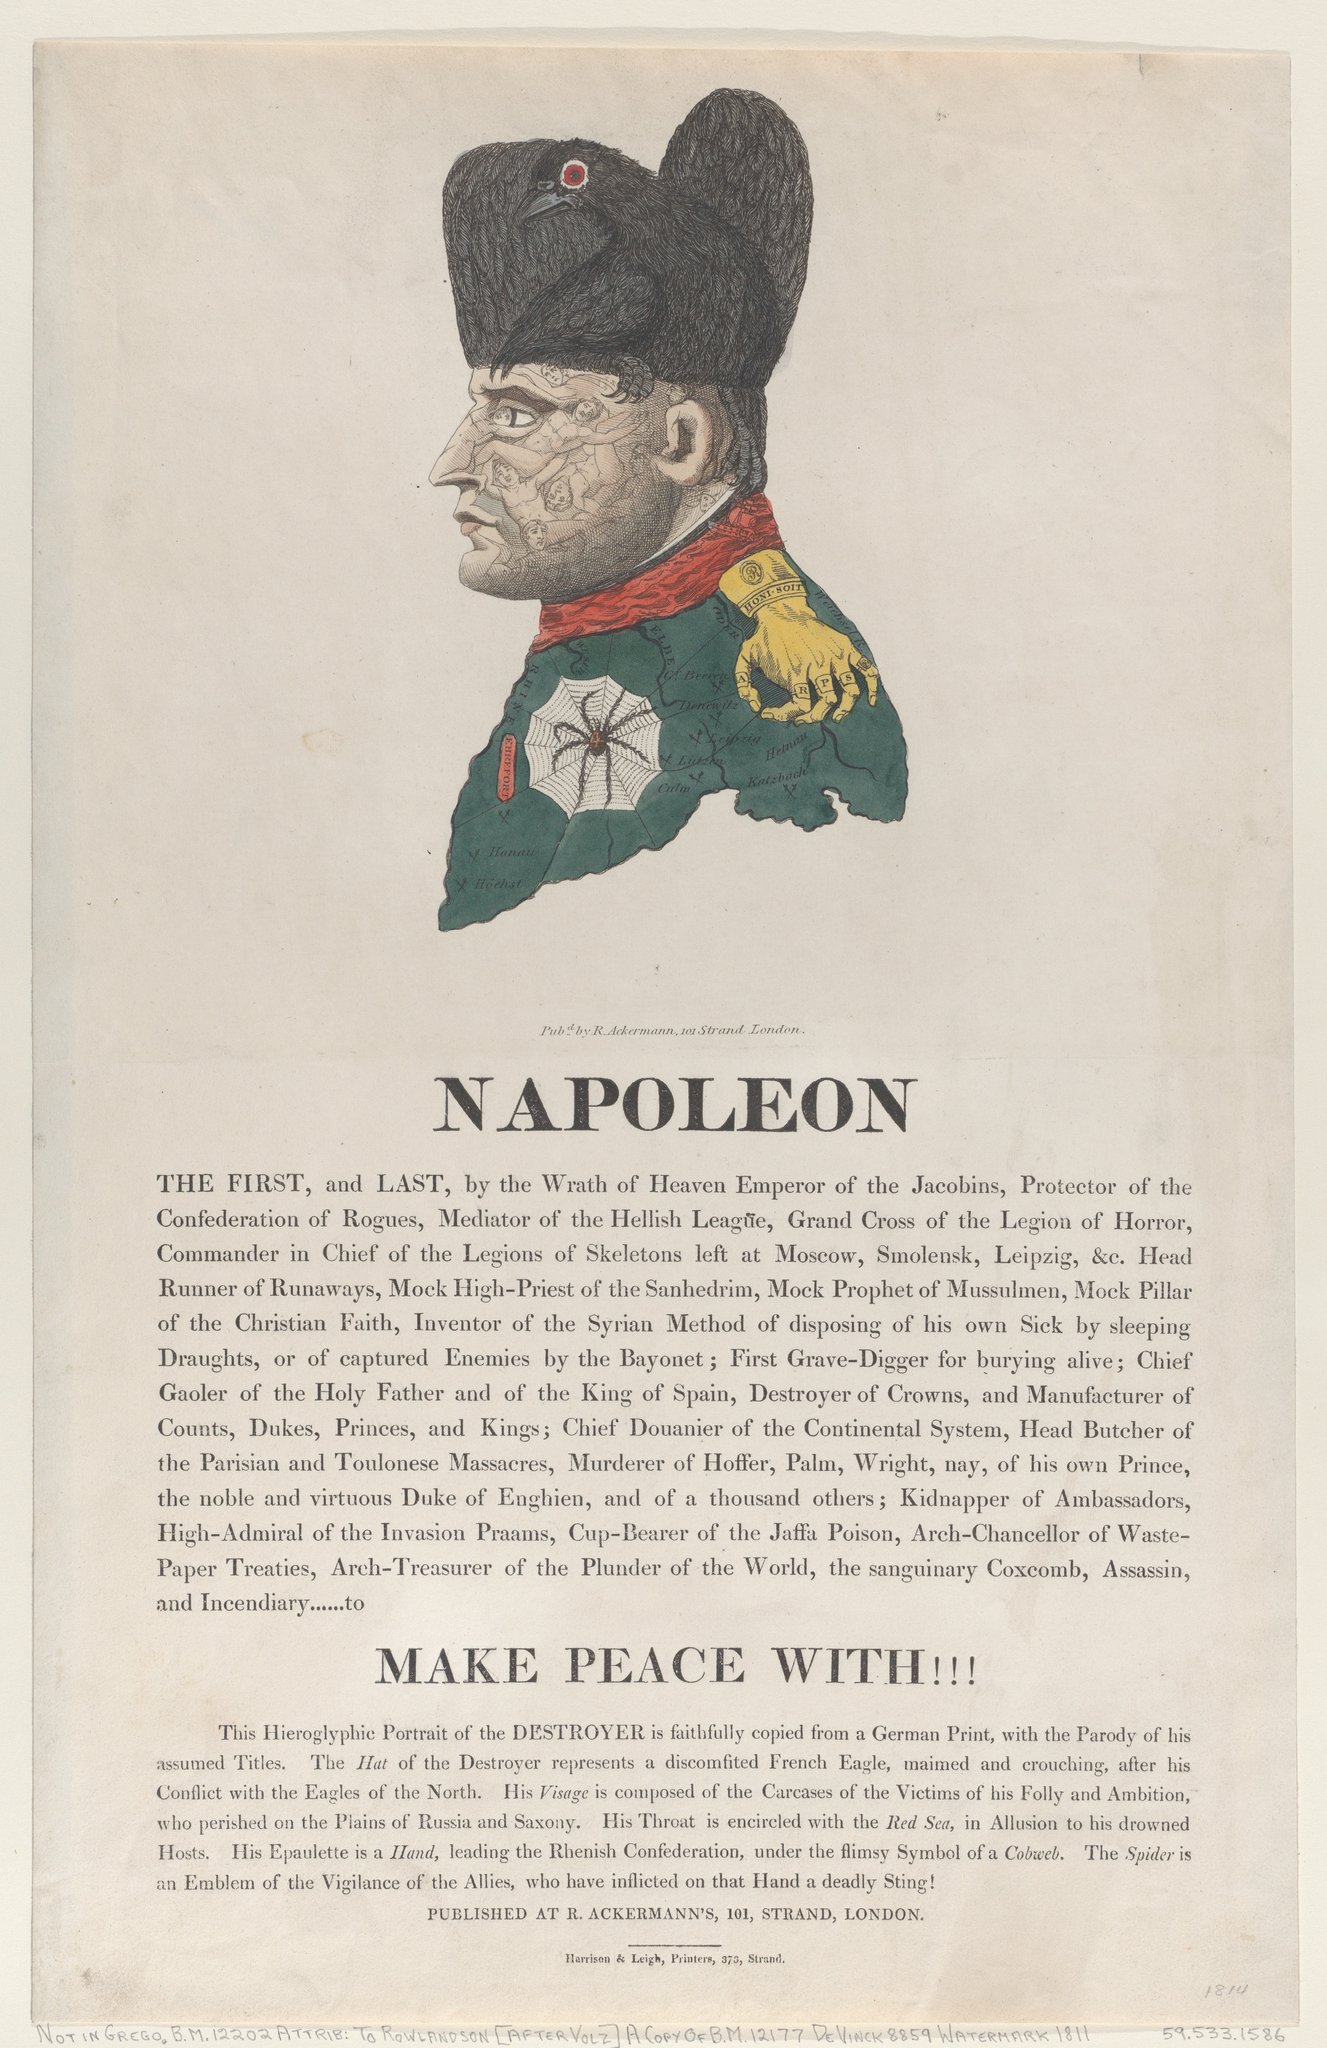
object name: print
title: Napoleon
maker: thomas rowlandson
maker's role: artist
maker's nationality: british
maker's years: 1757-1827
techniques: etching, letterpress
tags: eagles,satire,napoleon i,hands,spiders